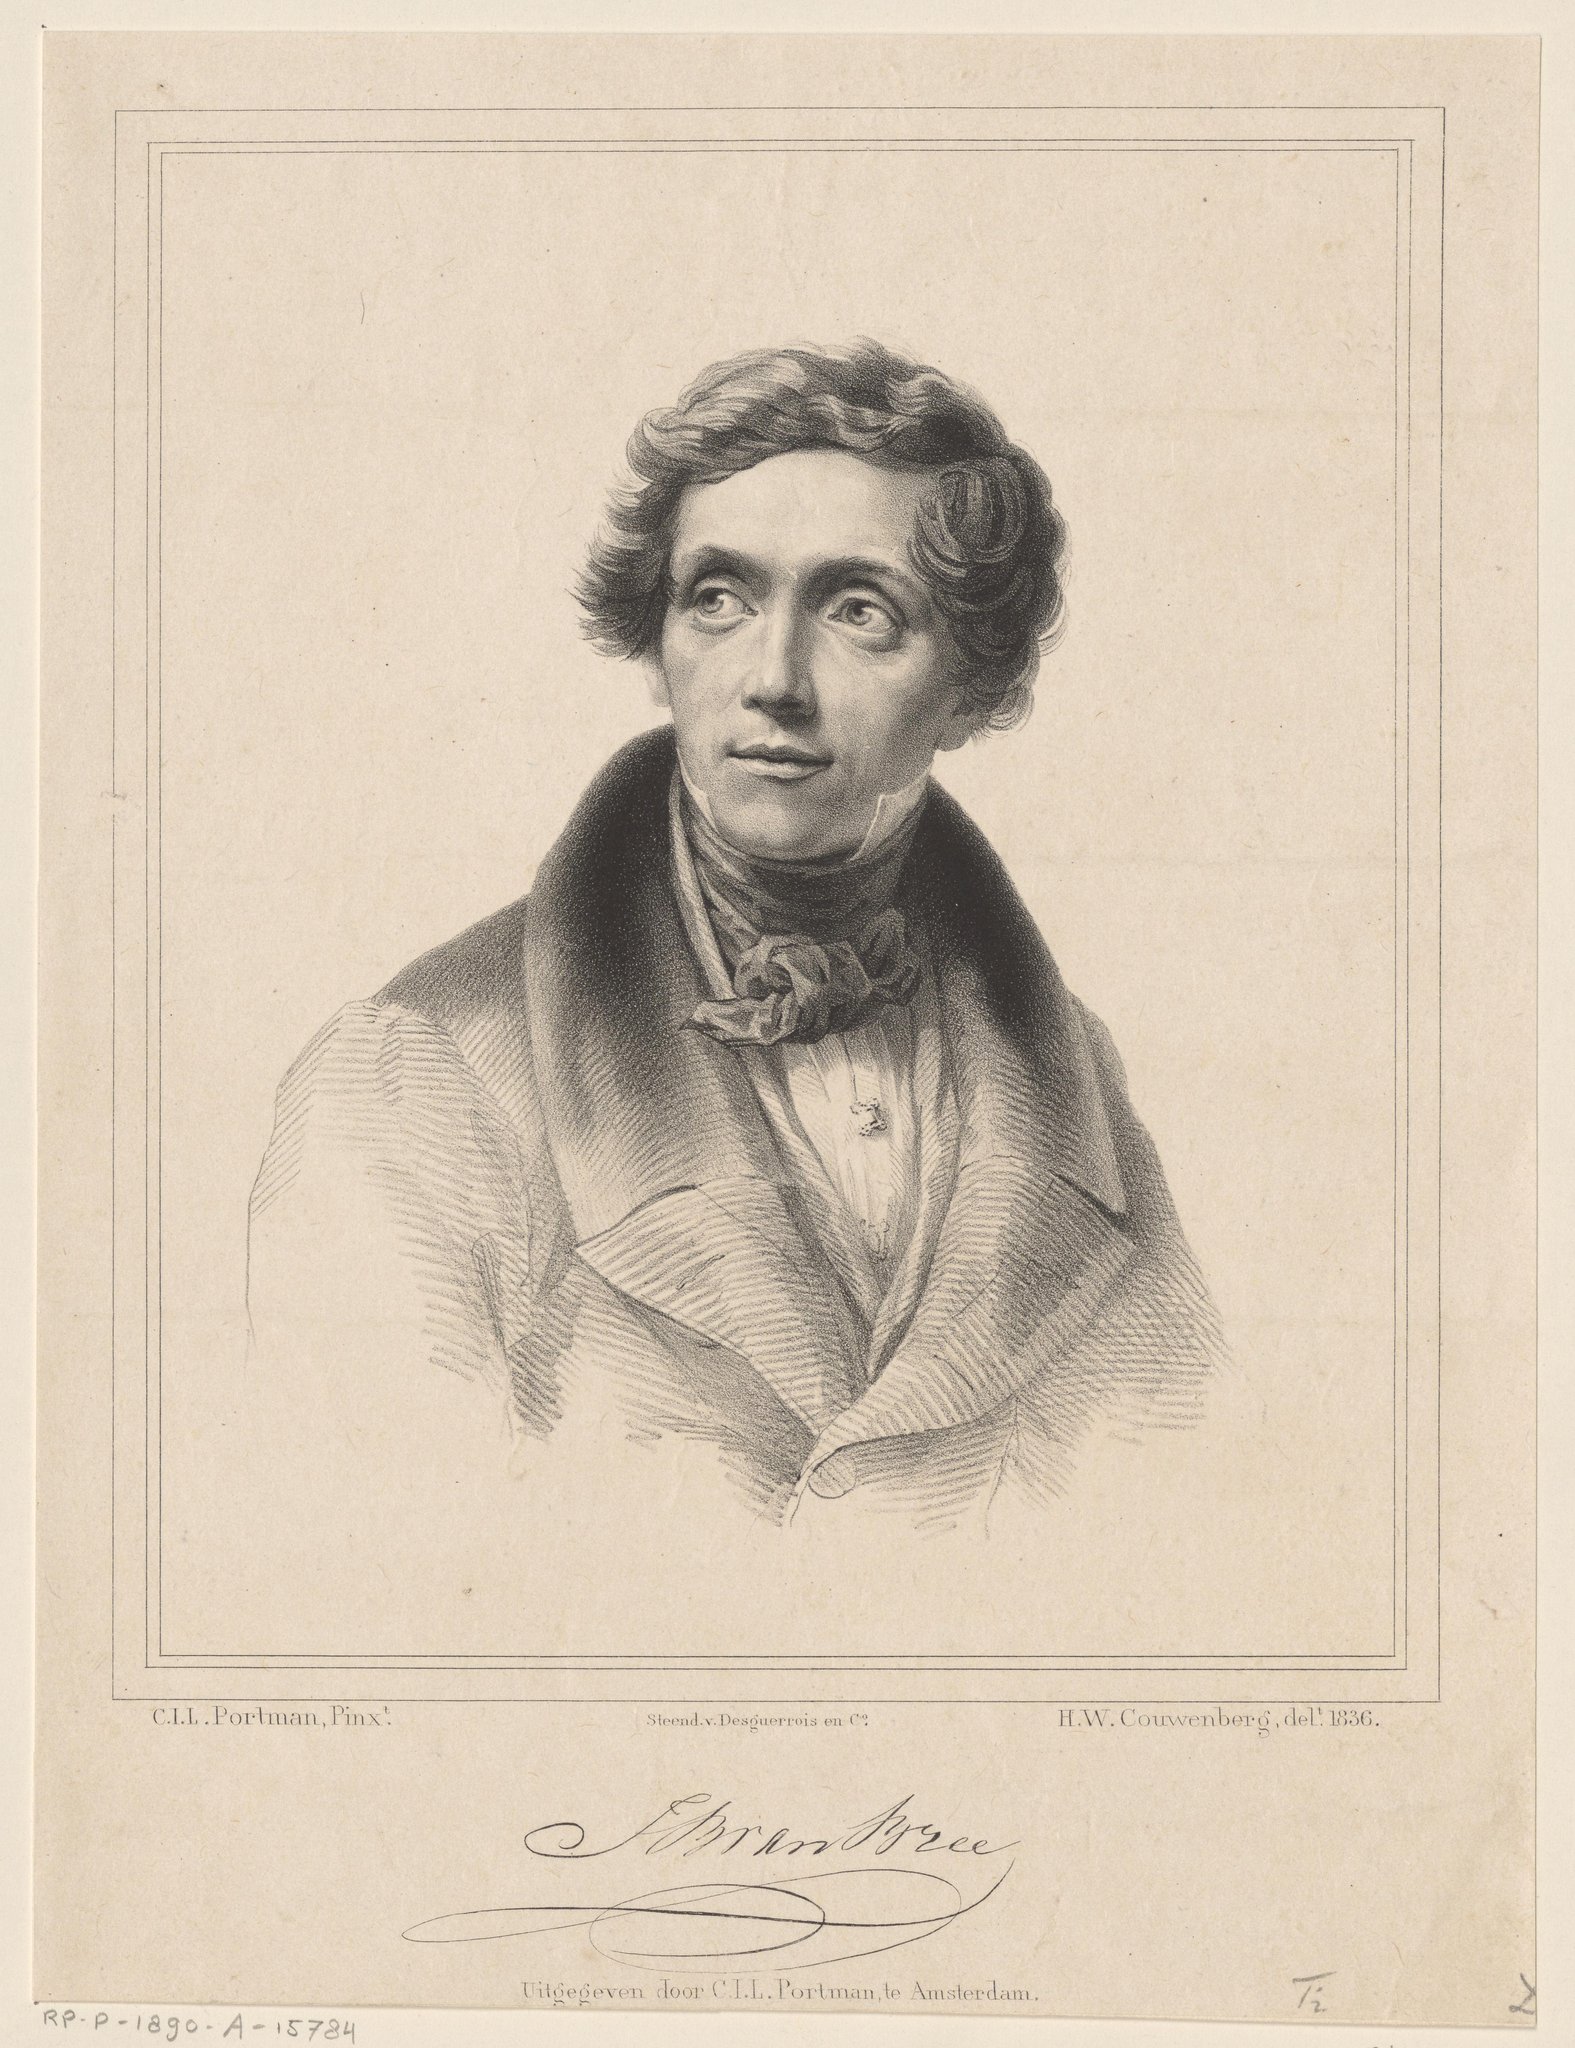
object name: print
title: Portret van Johannes Bernardus van Bree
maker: christiaan julius lodewijk portman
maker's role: draughtsman, painter, print maker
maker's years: 1799-1868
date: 1836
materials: paper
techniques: lithograph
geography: amsterdam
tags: amsterdam, historical persons, portrait of composer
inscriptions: collector's mark: Lugt 2228